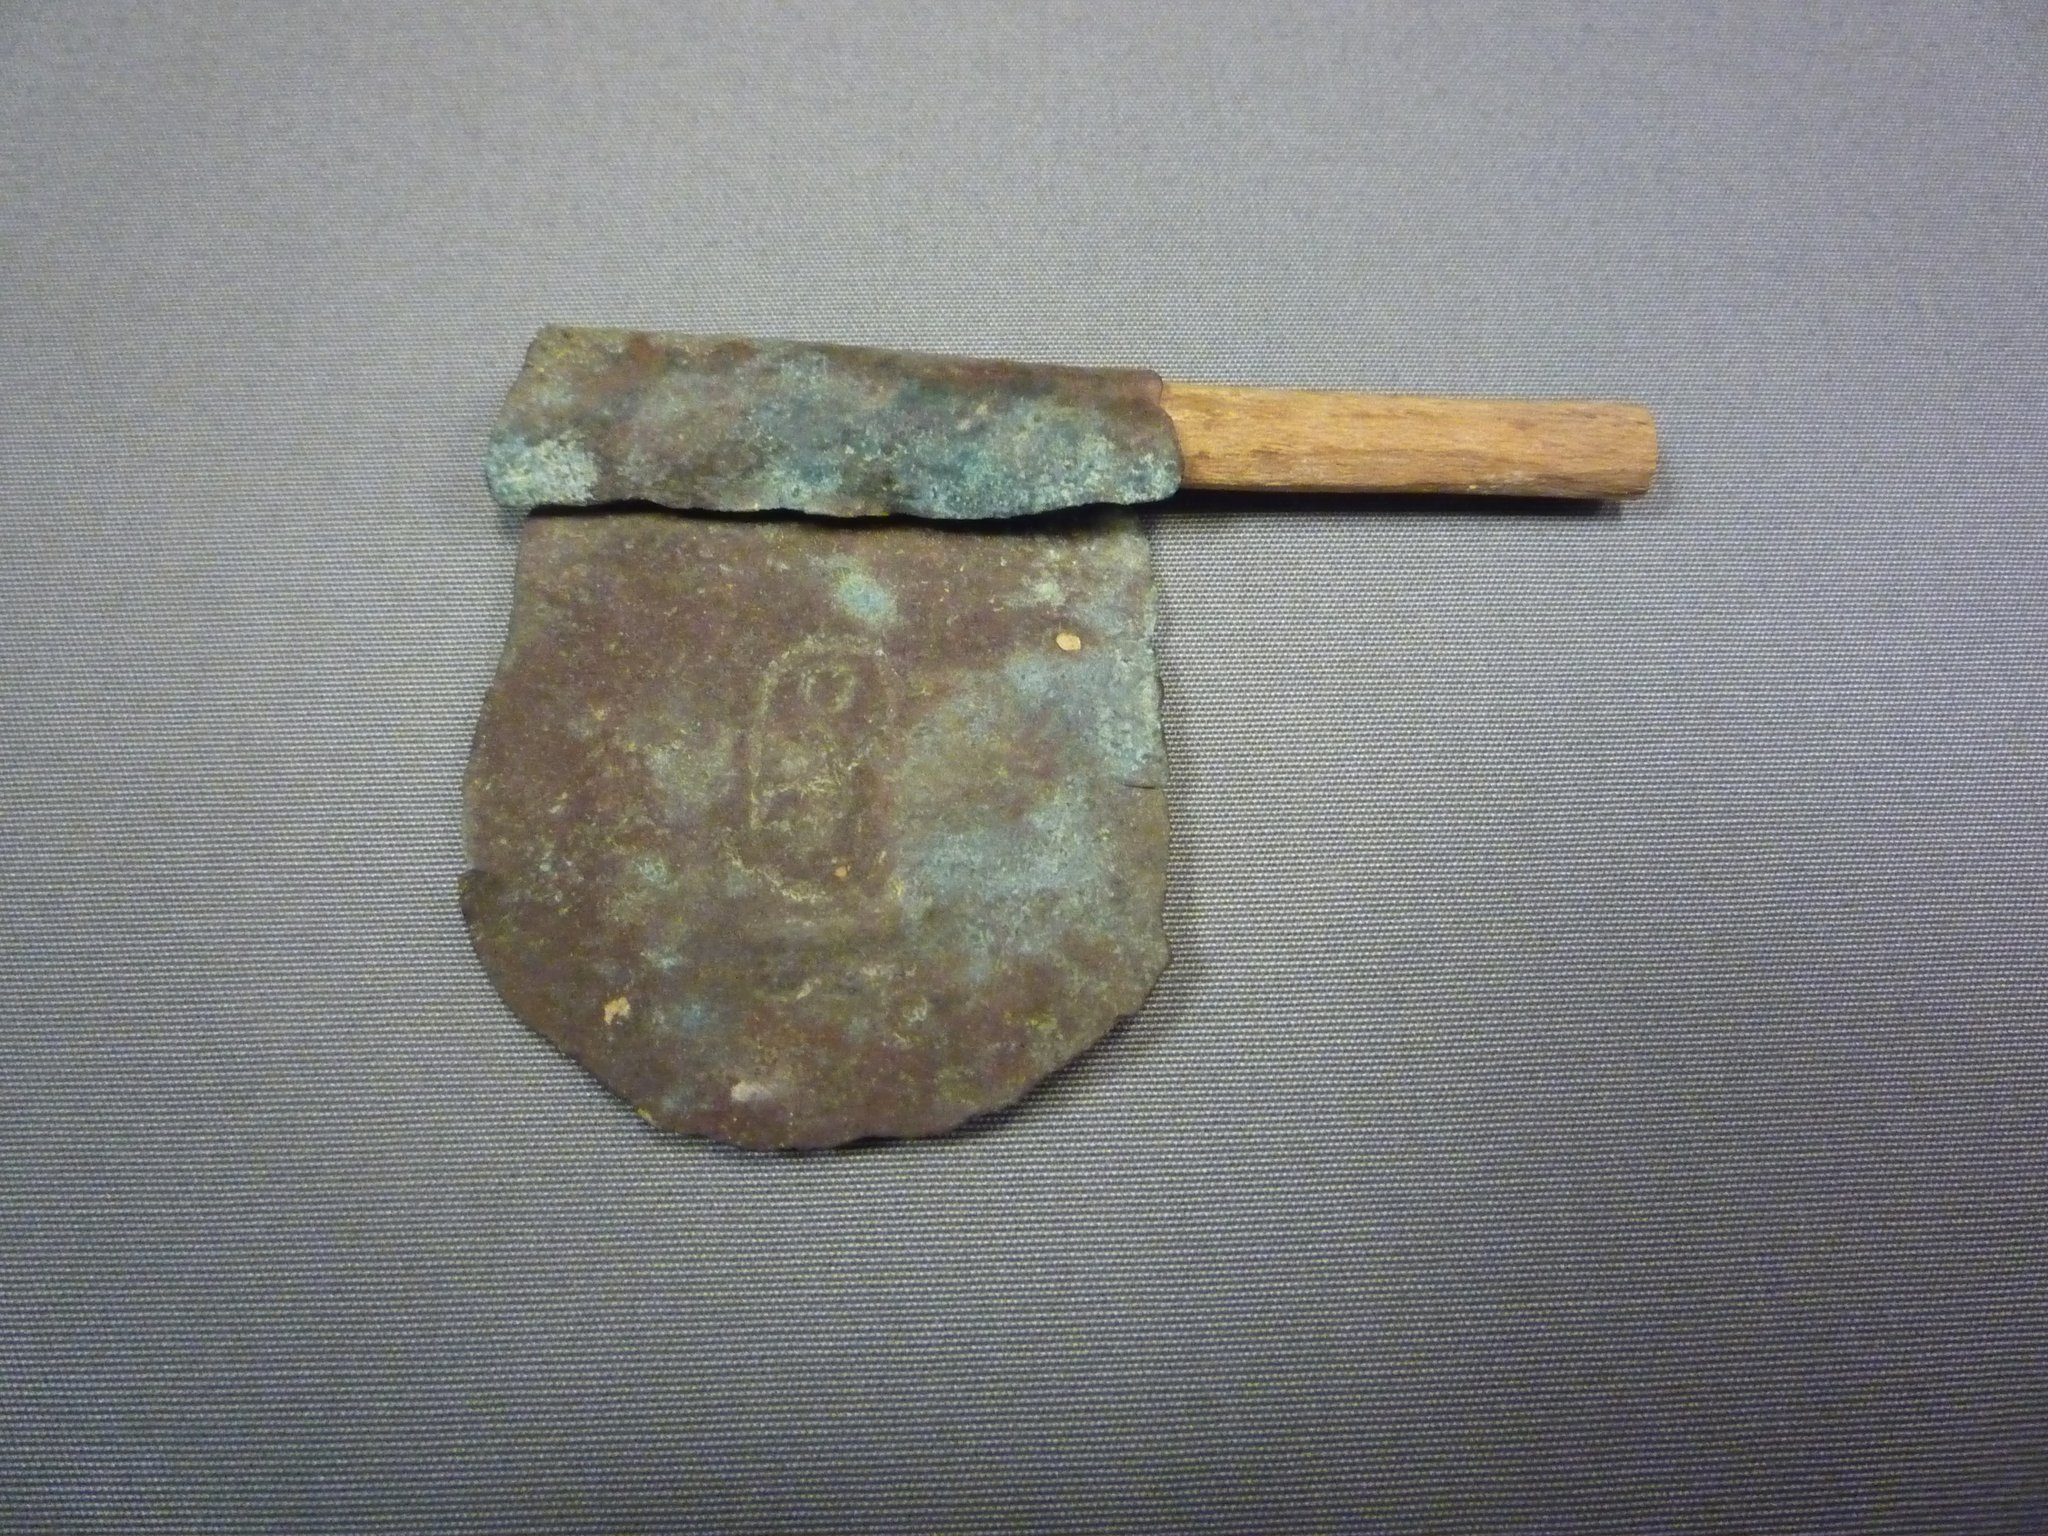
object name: model ax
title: Model Ax from the Foundation Deposit for Hatshepsut's Tomb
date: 1479-1458 BCE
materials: bronze, copper alloy, wood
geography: egypt